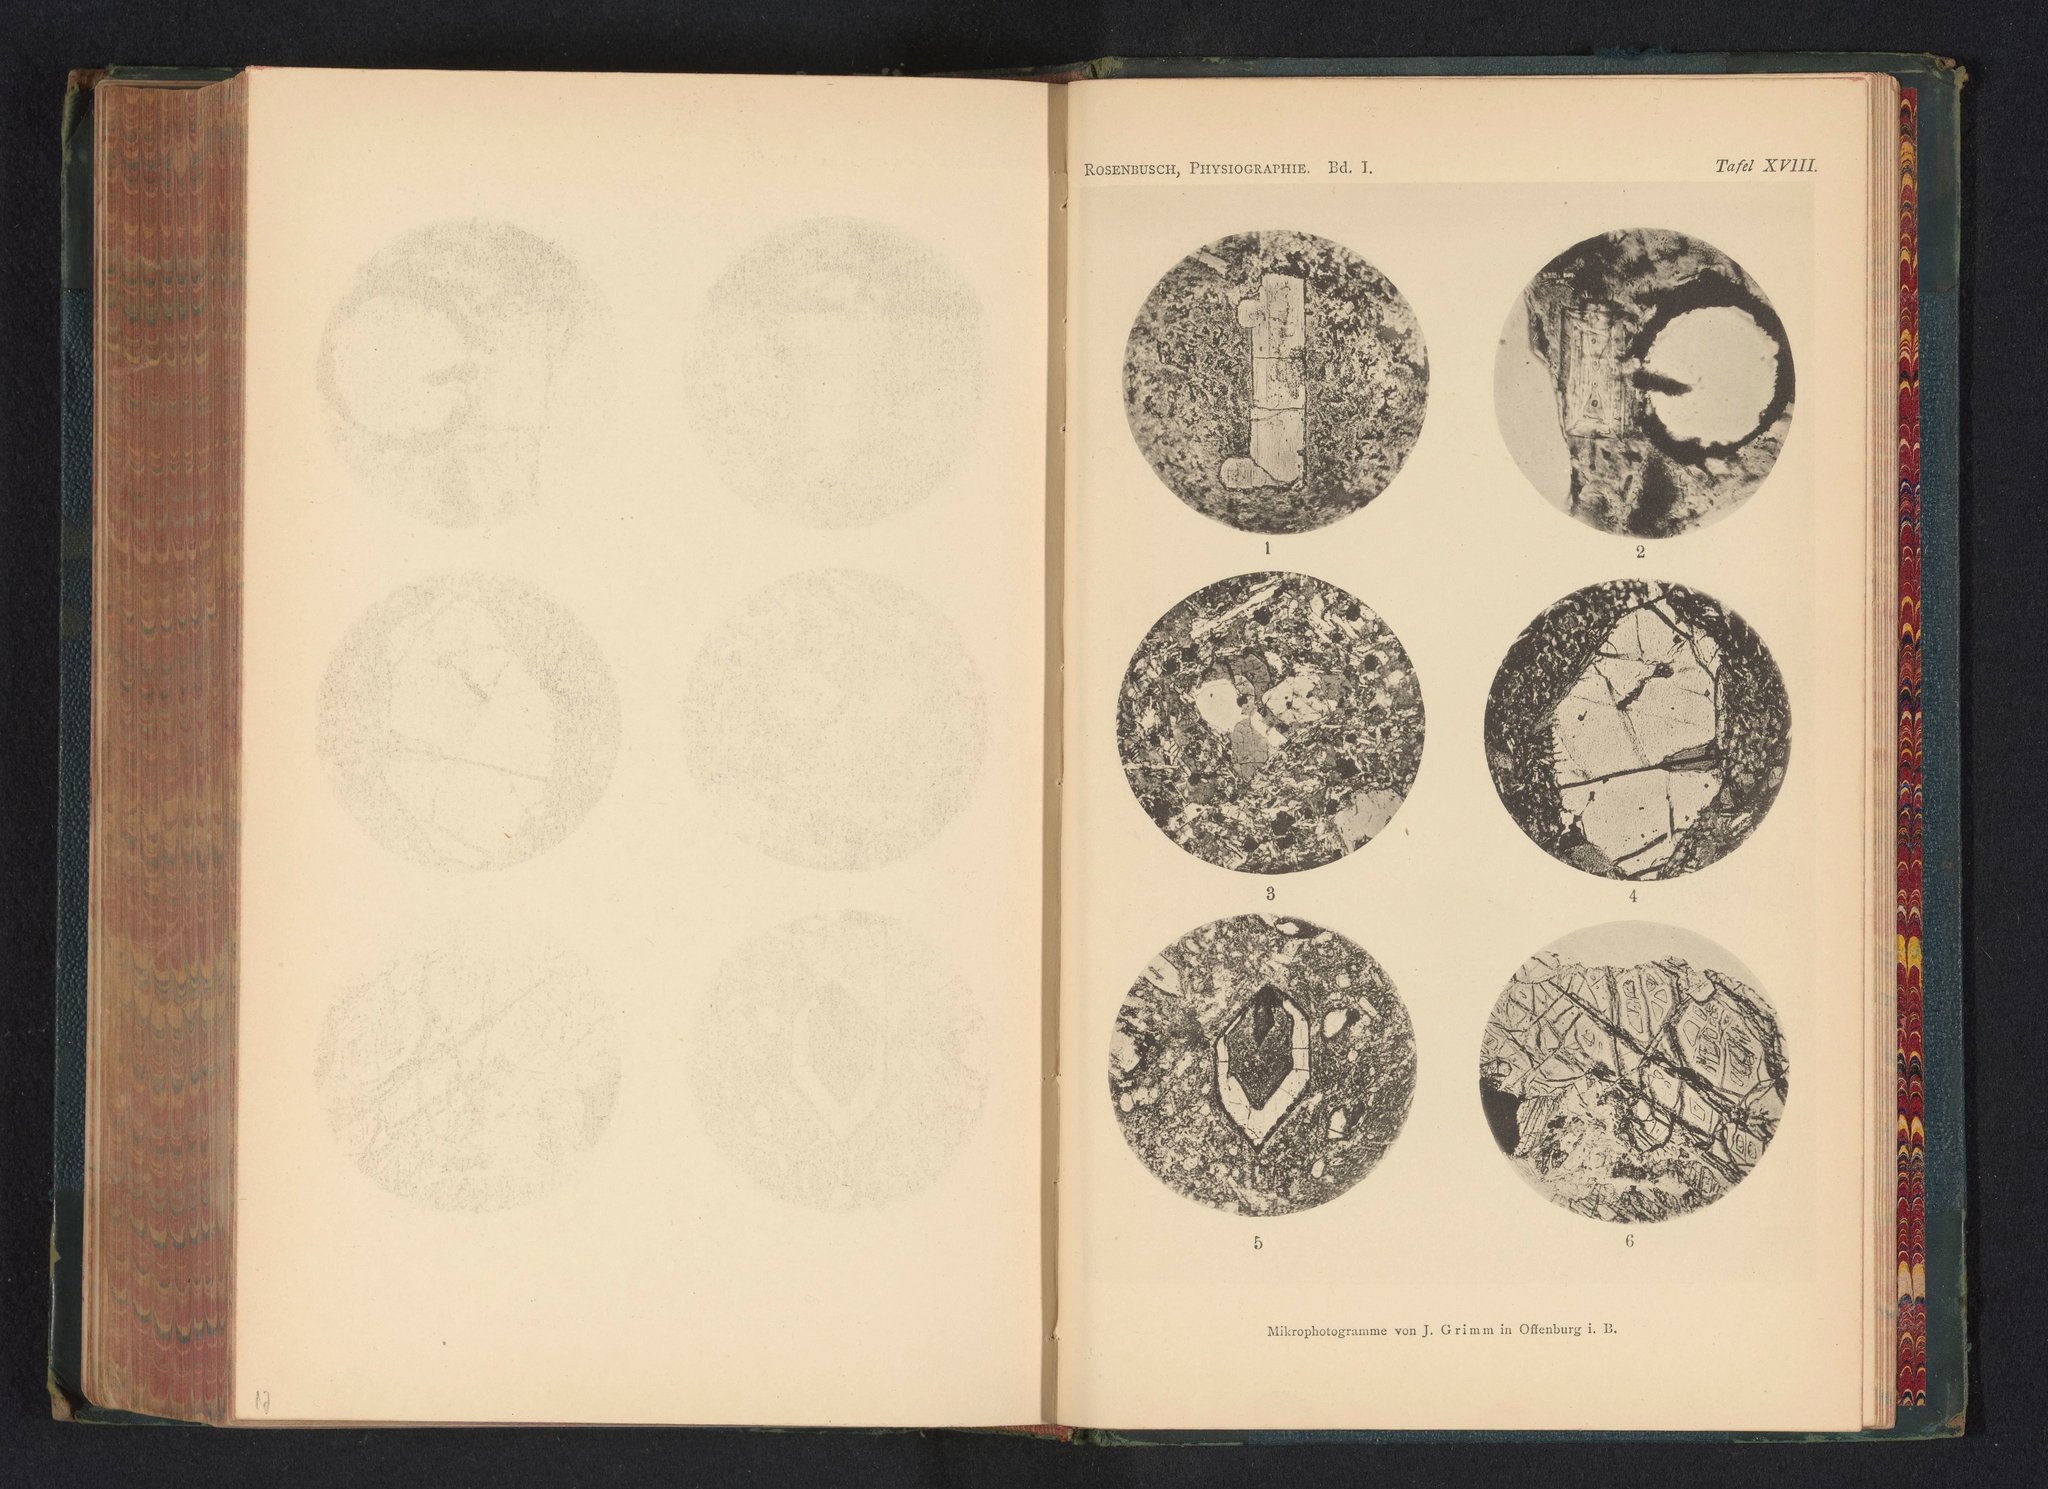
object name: photomechanical print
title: Zes microscopische vergrotingen van mineralen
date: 1880-1885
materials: paper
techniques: photograph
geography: greifswald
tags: minerals and metals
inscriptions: number: ‘1 (...) 6’, number: ‘Tafel XVIII’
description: Afbeelding 1 is enstatiet, 2 is olivine, 3 is nefelienbasalt, 4 is basalt, 5 is olivine en 6 is olivine.